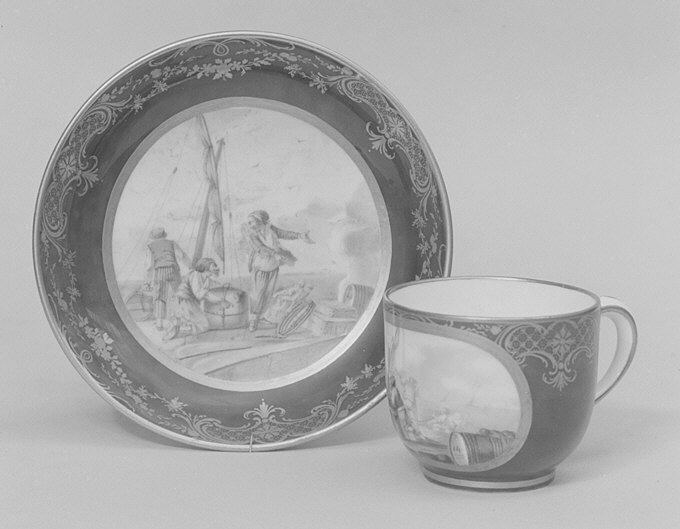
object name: cup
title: Cup (gobelet Bouillard) (part of a service)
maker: sèvres manufactory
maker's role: manufactory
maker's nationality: french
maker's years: 1740-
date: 1775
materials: soft paste porcelain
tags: men,working